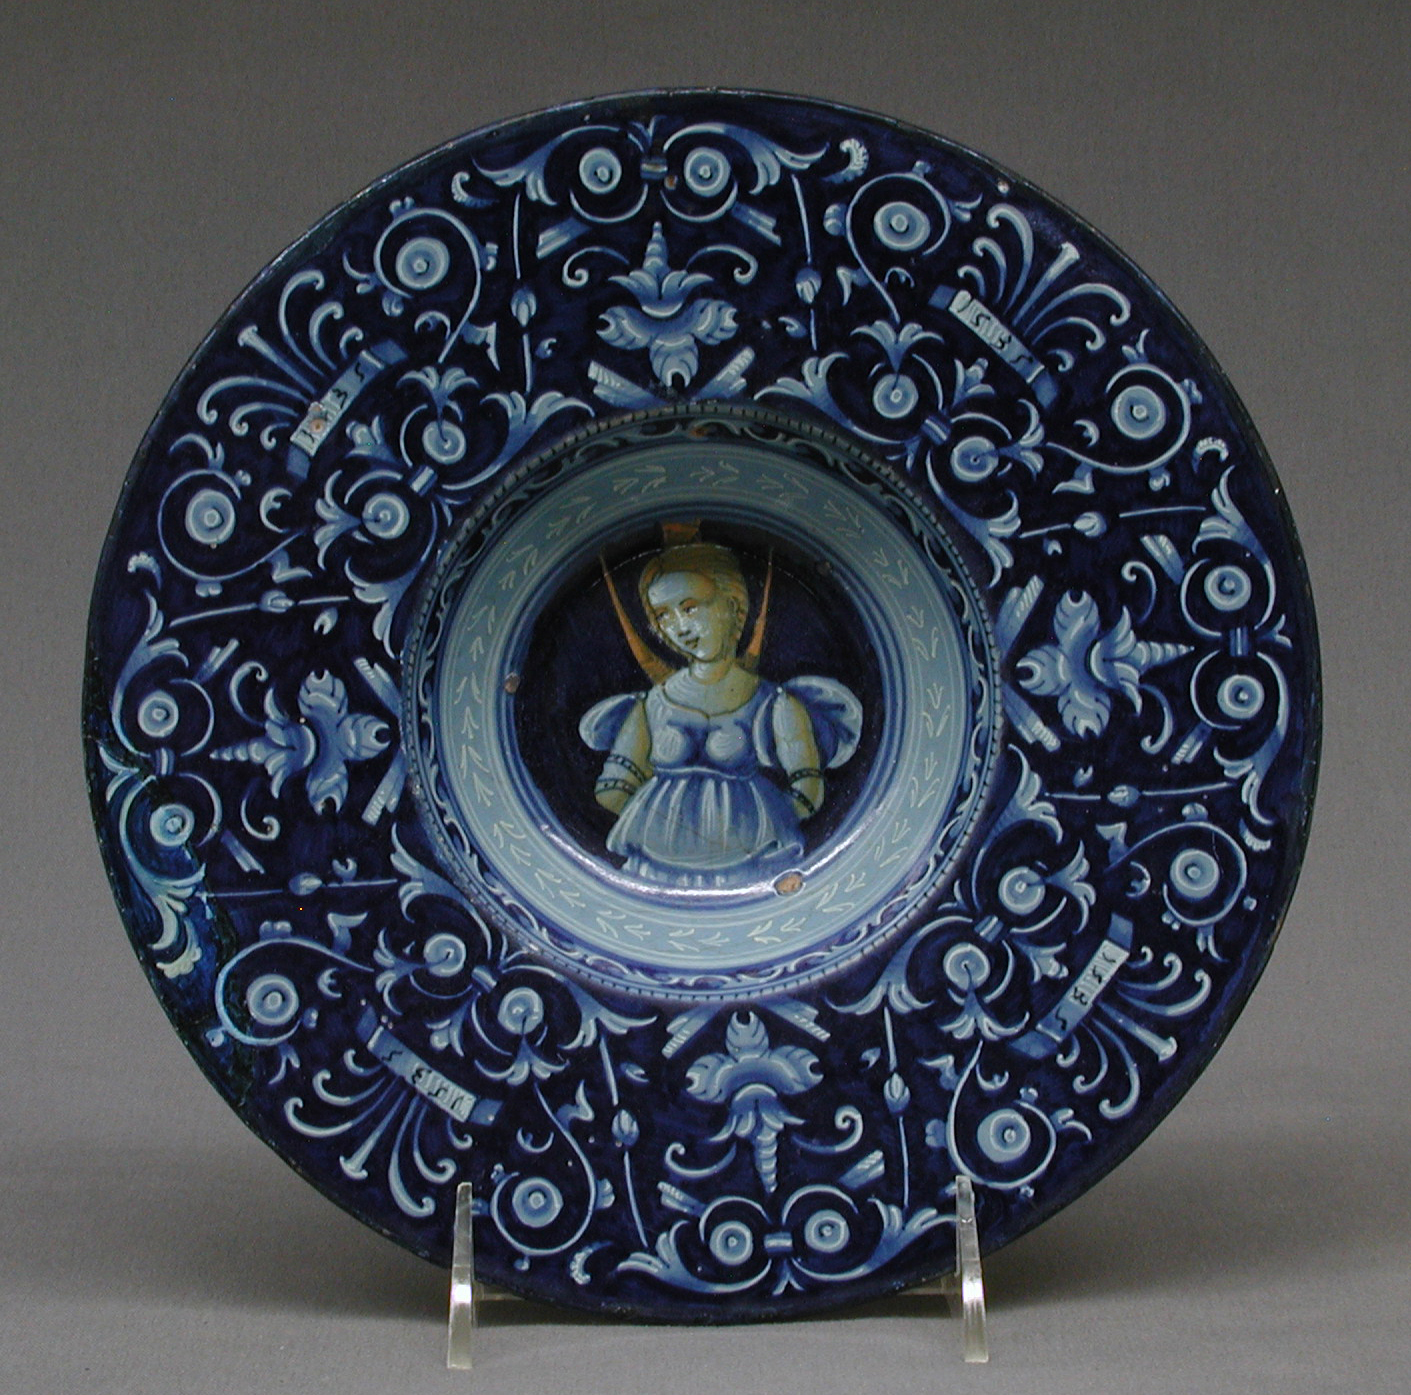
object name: dish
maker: casa pirota manufactory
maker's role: maker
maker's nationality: italian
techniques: maiolica, glazing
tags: portraits,women